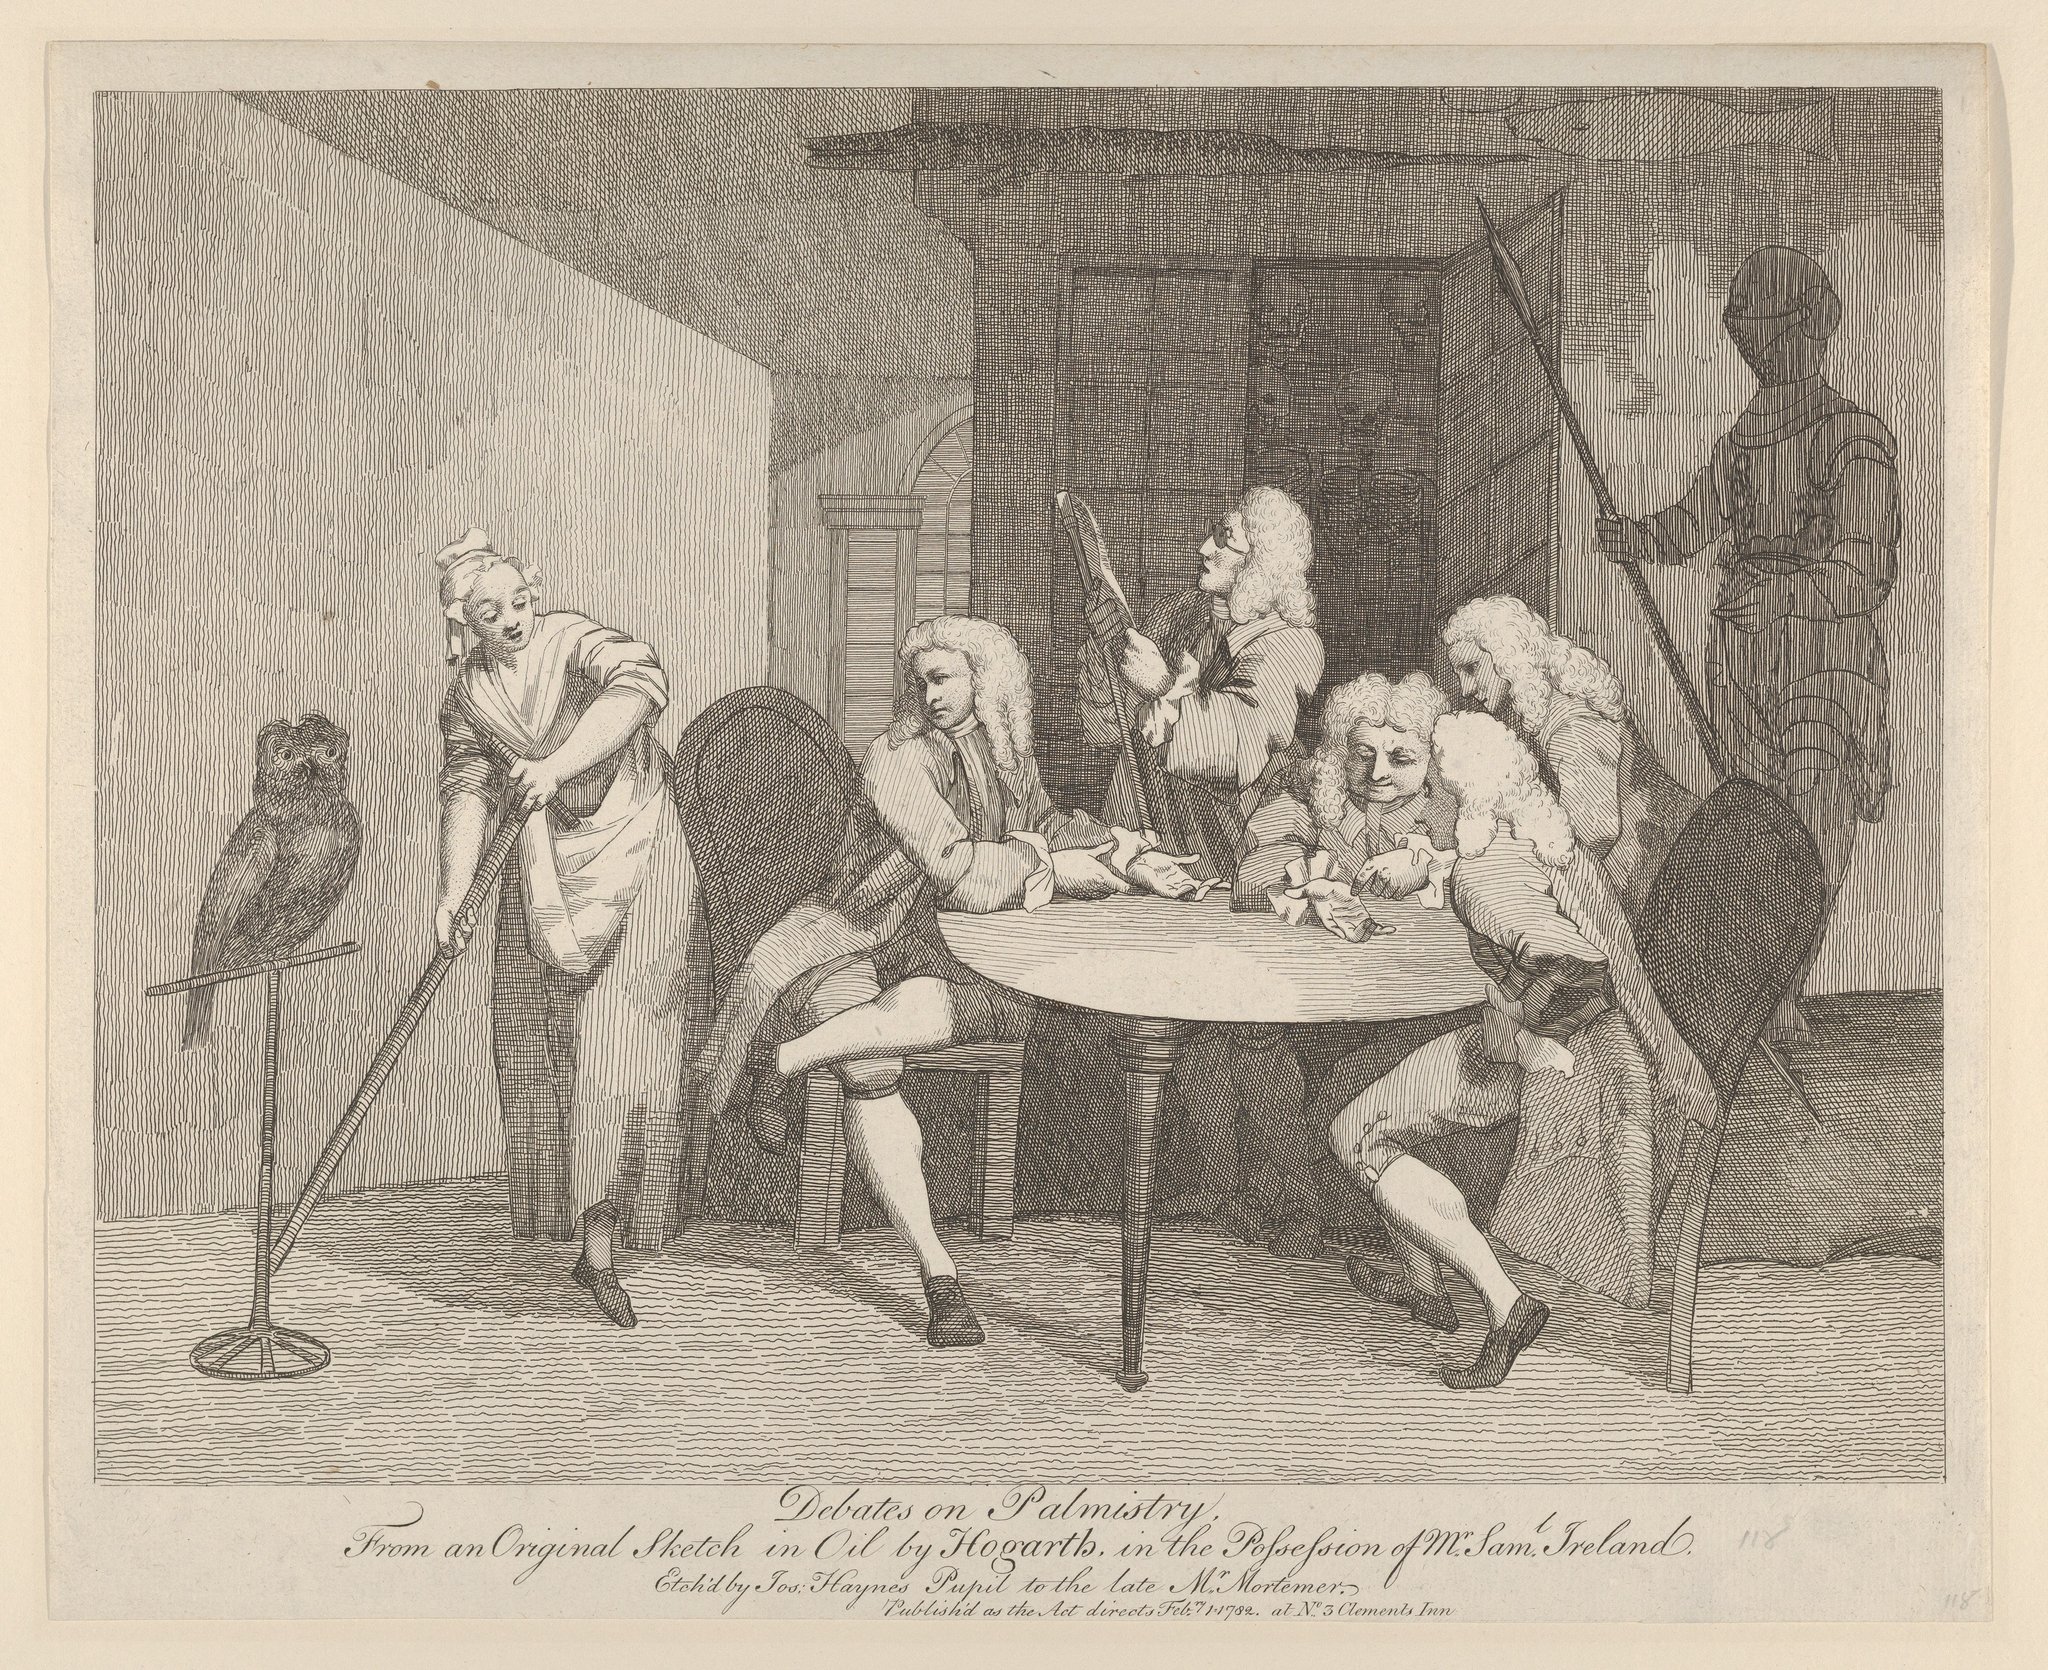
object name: print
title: Debates on Palmistry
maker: joseph haynes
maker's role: etcher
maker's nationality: british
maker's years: 1760-1829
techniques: etching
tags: birds,men,women